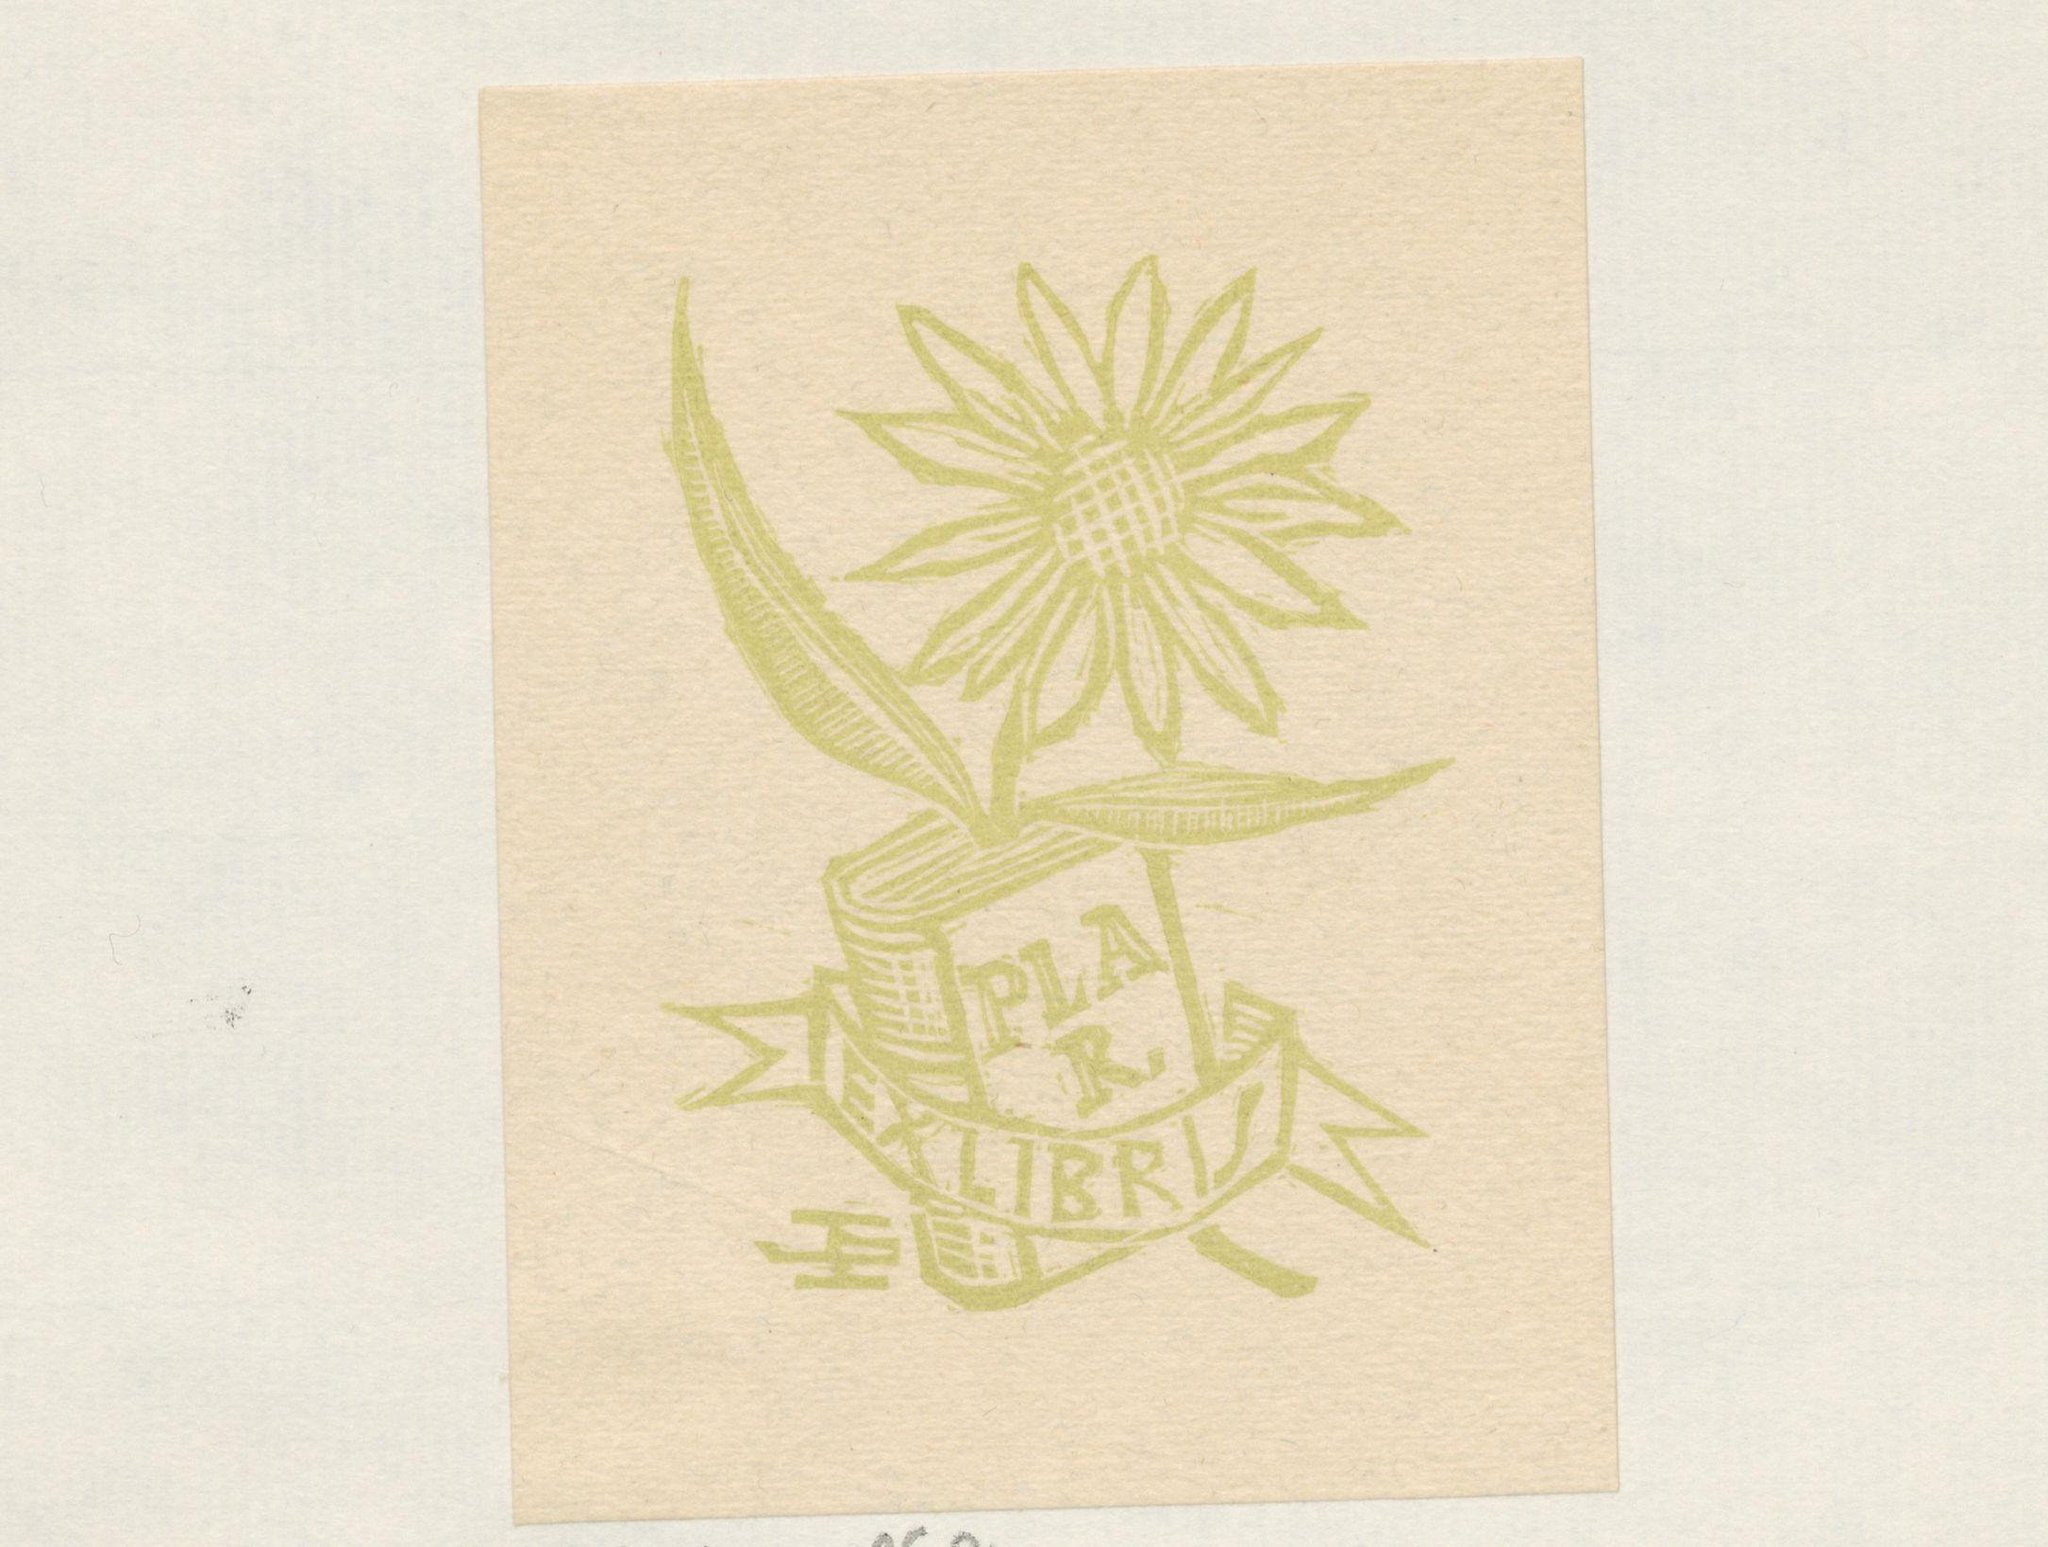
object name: bookplate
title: Ex libris Pla R.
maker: Anonymous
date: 1900-1999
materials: paper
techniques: woodcut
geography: czech republic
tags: flowers, book